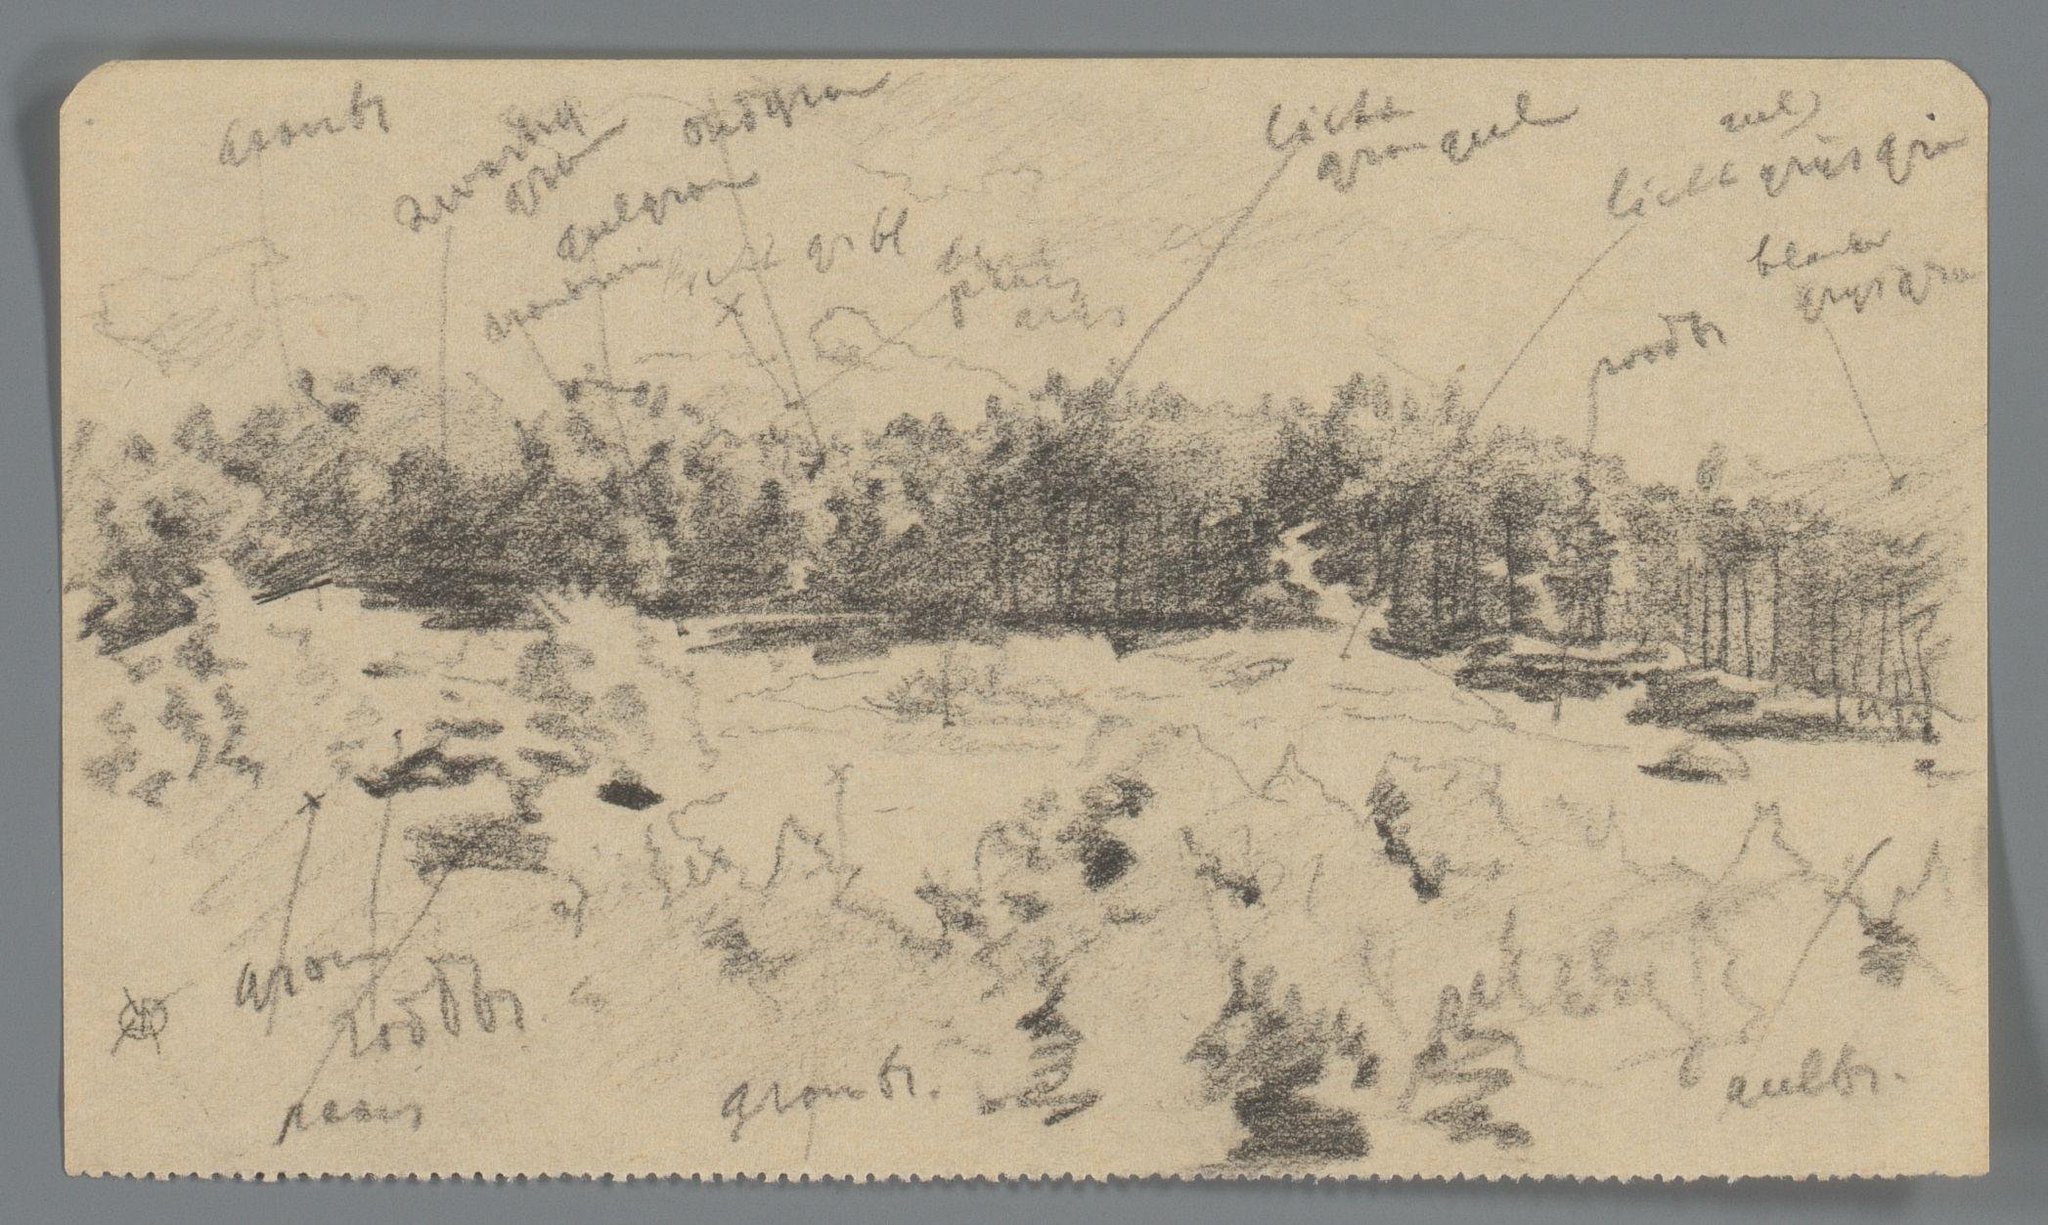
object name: drawing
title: Gezicht op een bos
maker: gerrit willem dijsselhof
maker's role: designer, draughtsman, print maker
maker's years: 1866-1924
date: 1876-1924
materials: chalk, paper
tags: forest, wood